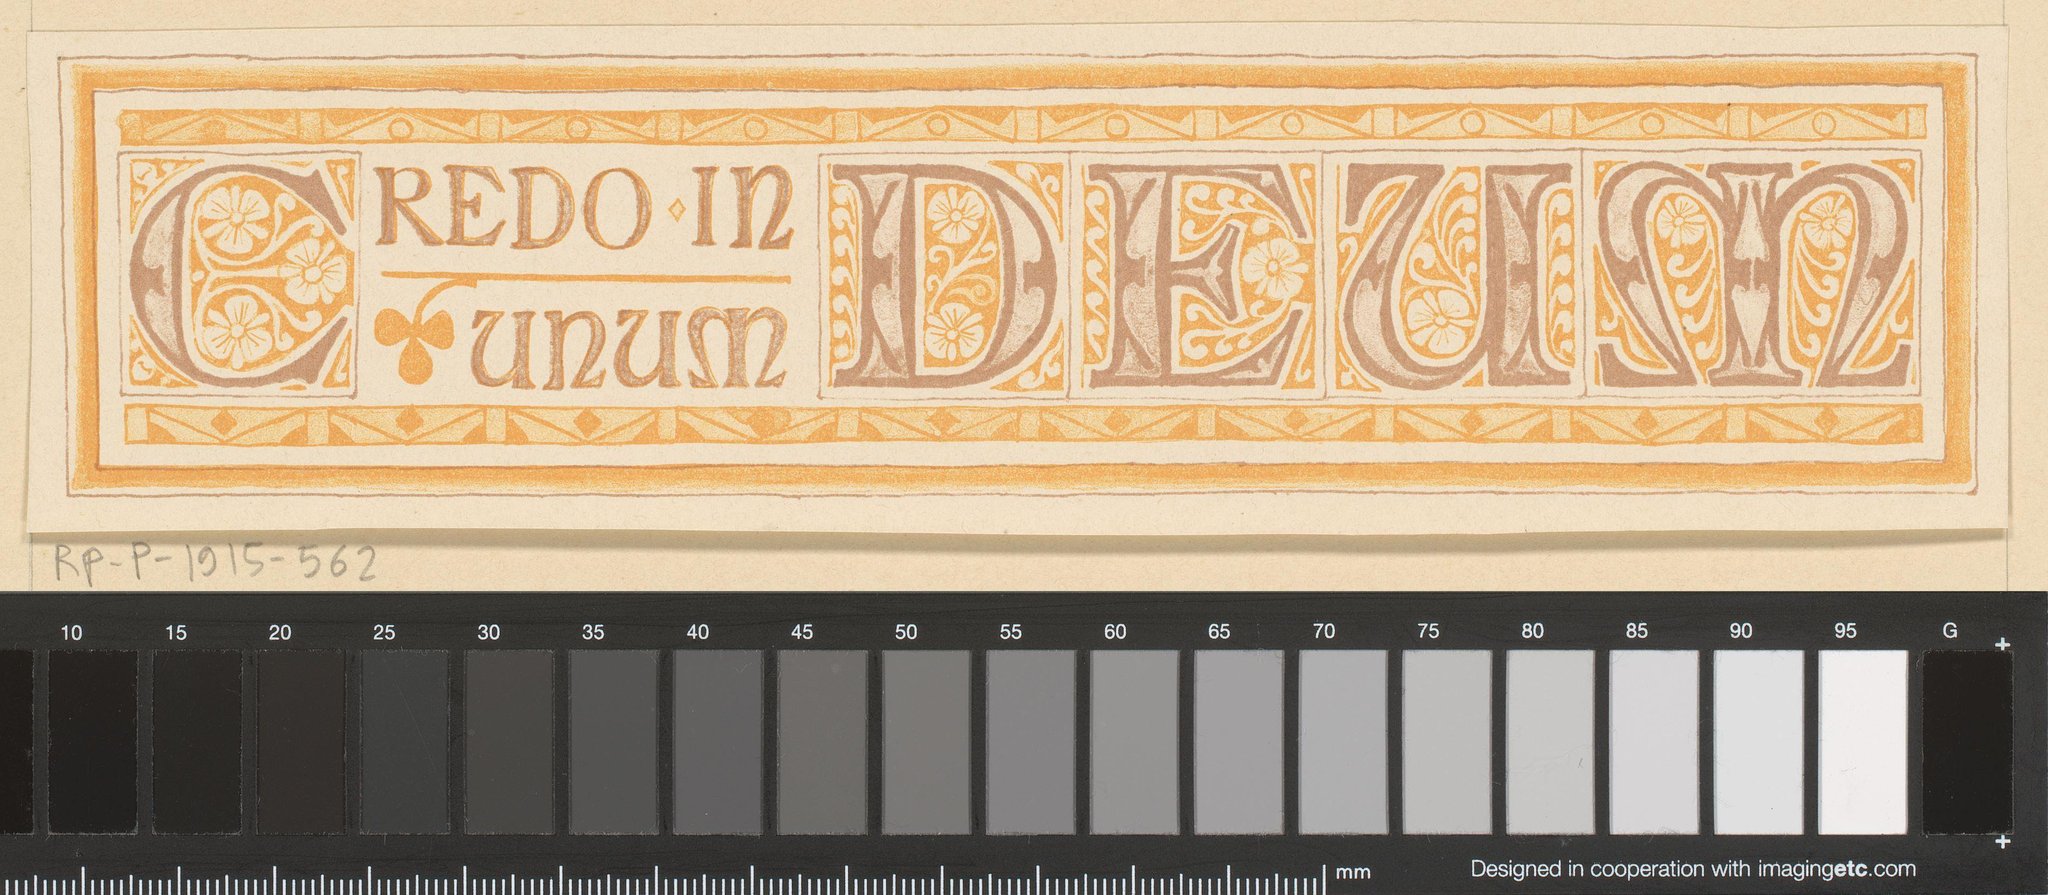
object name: print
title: Credo in unum Deum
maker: antoon derkinderen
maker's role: draughtsman, painter, print maker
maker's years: 1859-1925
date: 1895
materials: paper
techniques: lithograph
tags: ornament derived from plant forms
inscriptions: collector's mark: Lugt 2233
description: Prent gebruikt voor: Diepenbrock, Alphons. Missa. Amsterdam: Algemeene Muziekhandel, 1895.